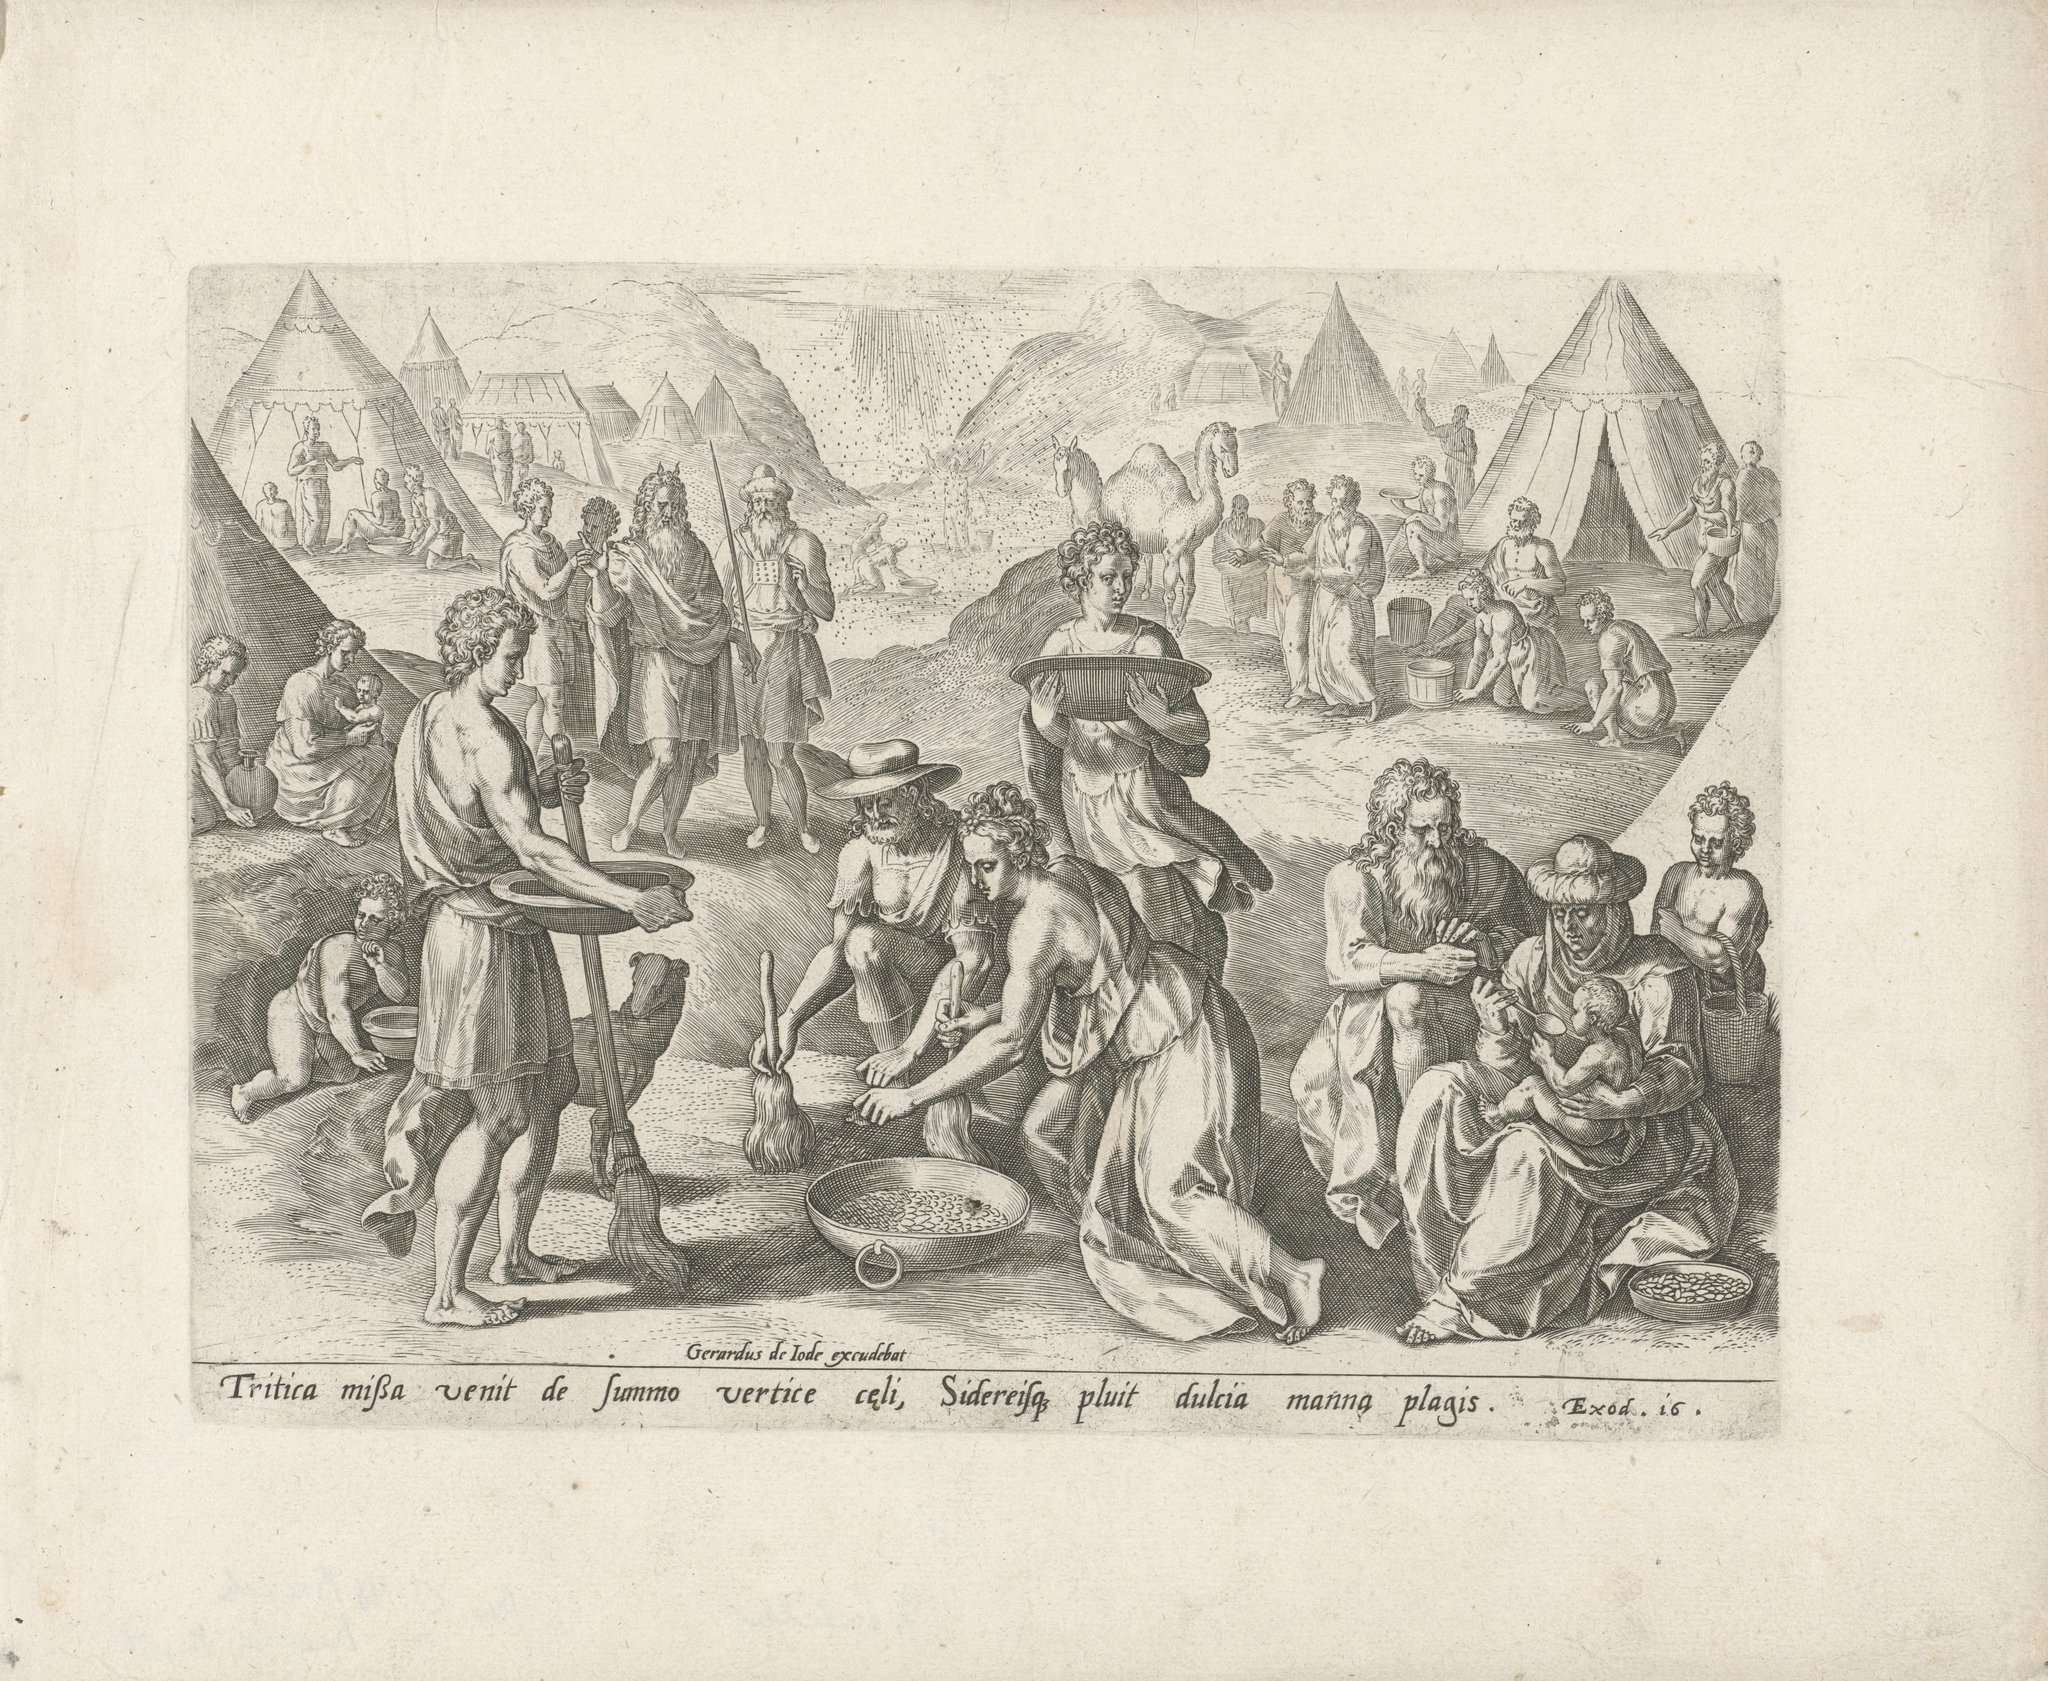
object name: print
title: Geschiedenis van Mozes na de Exodus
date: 1579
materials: paper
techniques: engraving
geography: antwerp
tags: the gathering of manna (in baskets and pots), in the morning manna falls to the earth ~ exodus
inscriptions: collector's mark: Lugt 2228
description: Het Joodse volk verzamelt manna in de woestijn. Op het tweede plan Mozes en Aäron. Op de achtergrond regent het manna uit de hemel. De prent heeft een Latijns opschrift en is de eerste prent van een zesdelige reeks over de geschiedenis van Mozes en het Joodse volk in de woestijn na de Exodus.